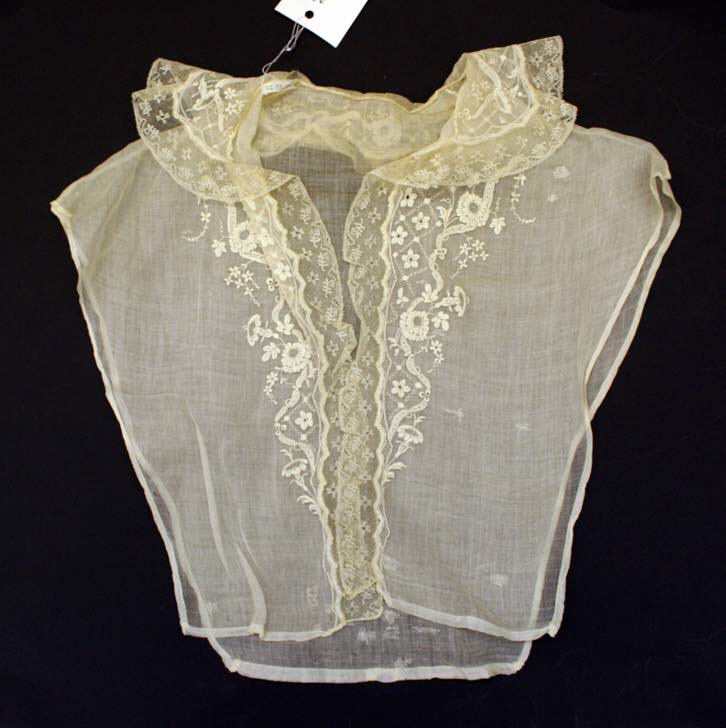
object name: chemise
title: Chemisette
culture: american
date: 1834-1866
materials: cotton